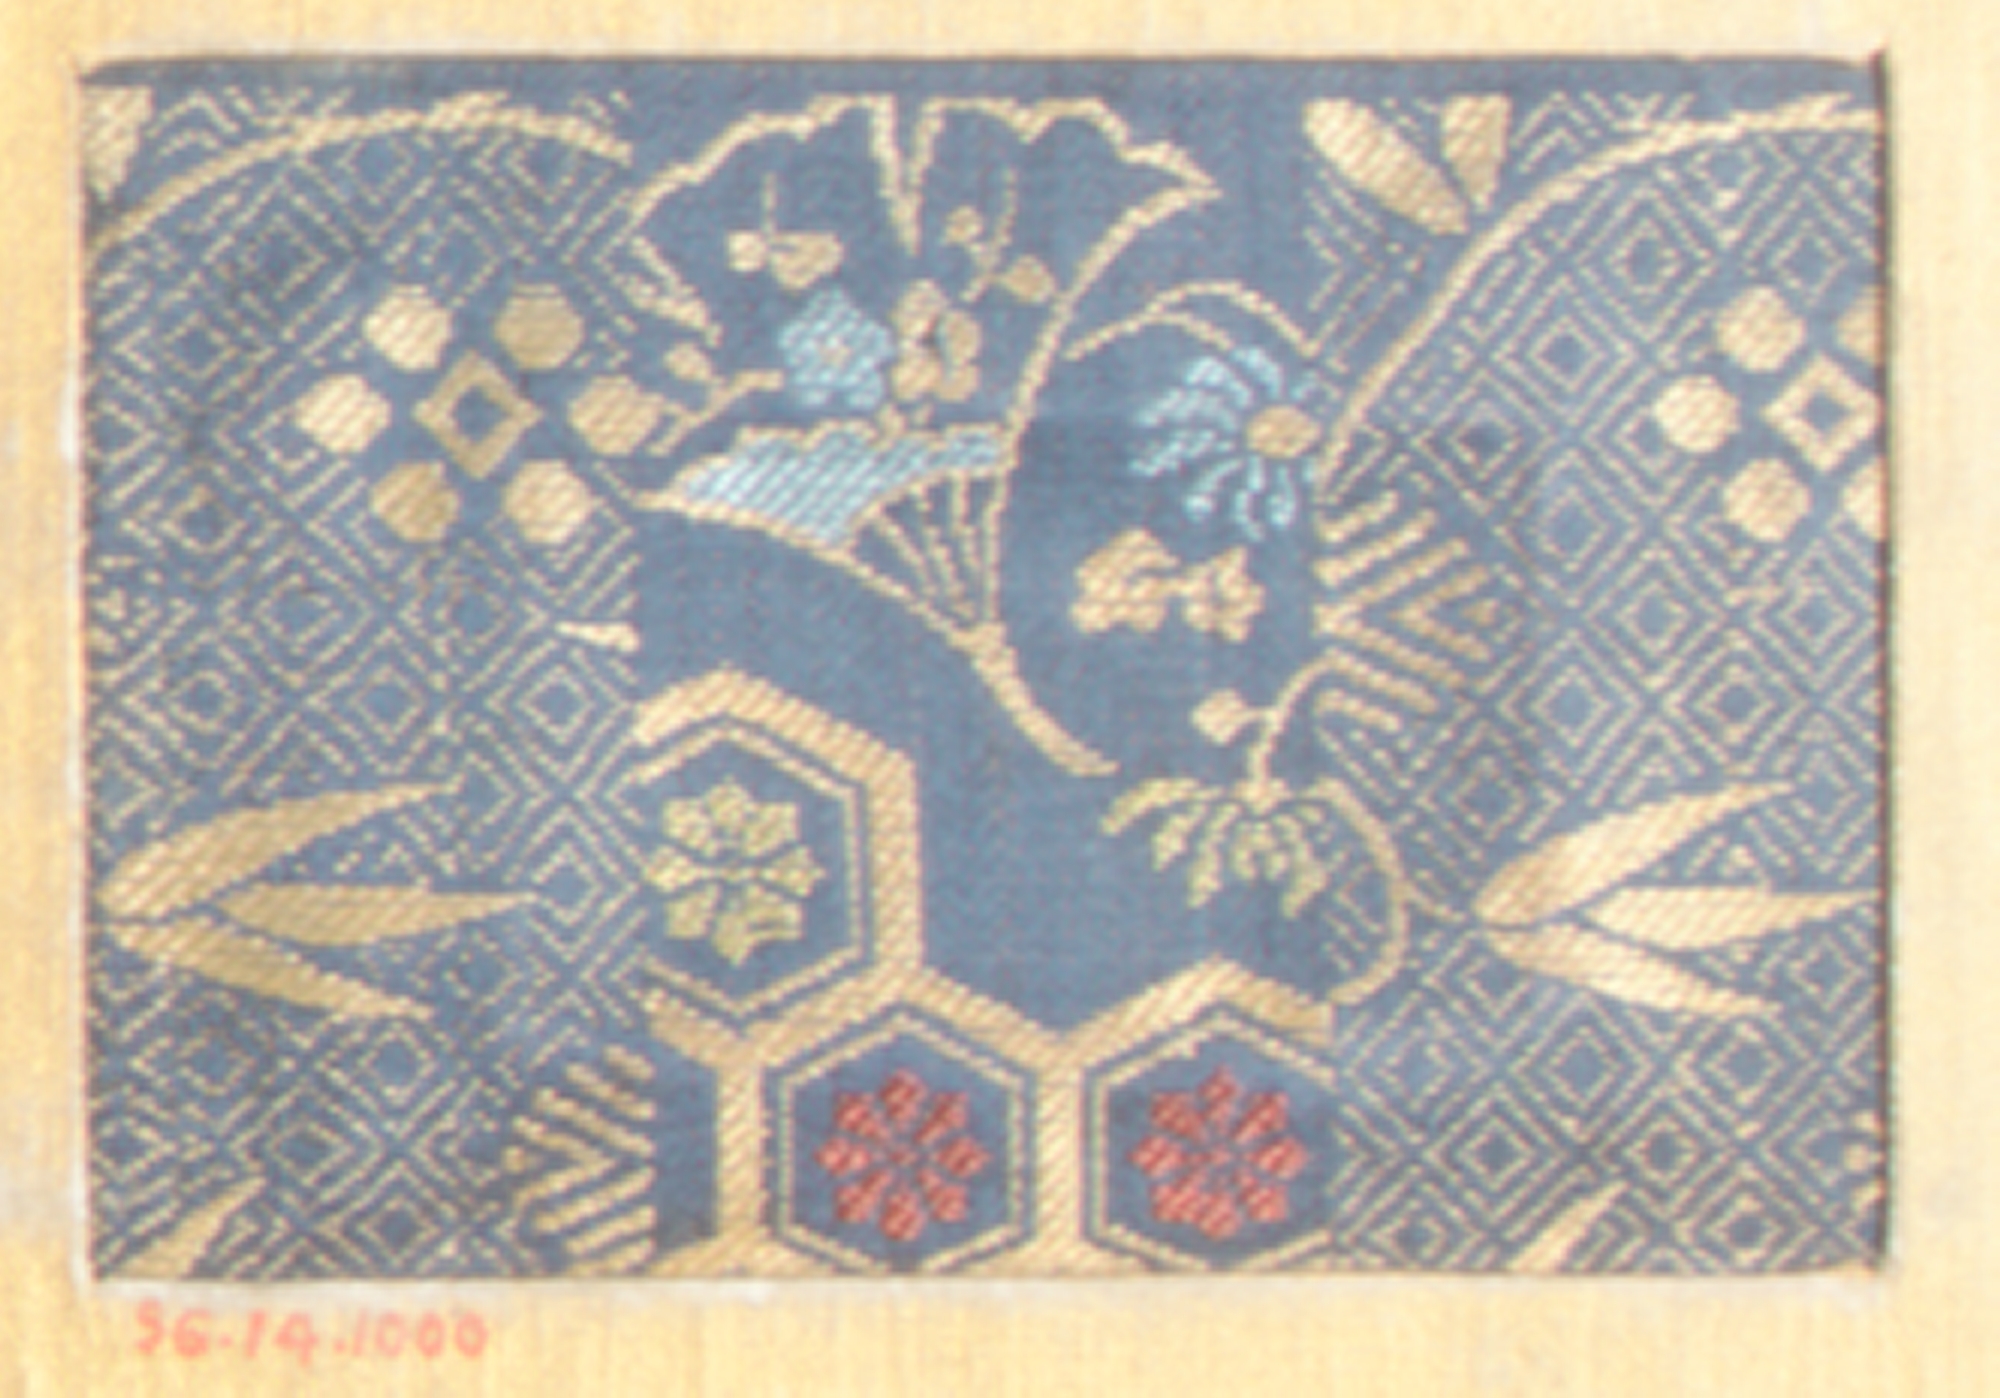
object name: piece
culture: japanese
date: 1701-1900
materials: silk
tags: flowers